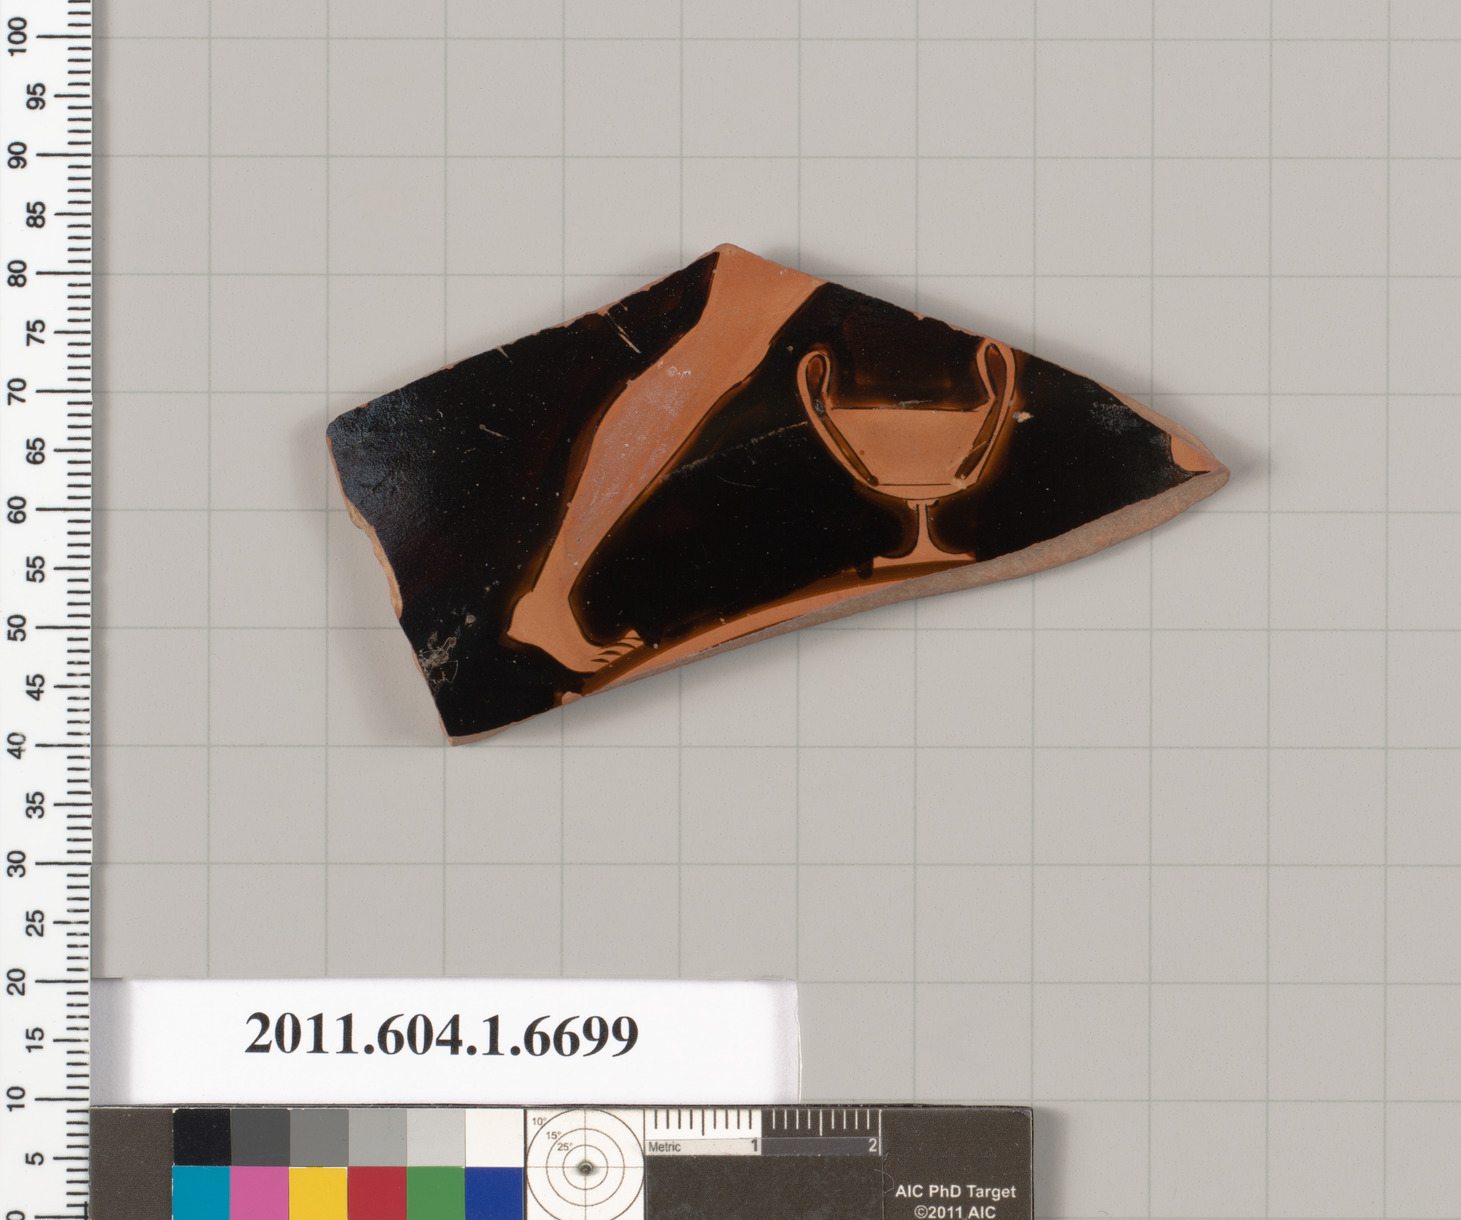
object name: kylix fragment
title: Terracotta fragment of a kylix (drinking cup)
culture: greek, attic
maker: dokimasia painter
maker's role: artist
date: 490-470 BCE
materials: terracotta